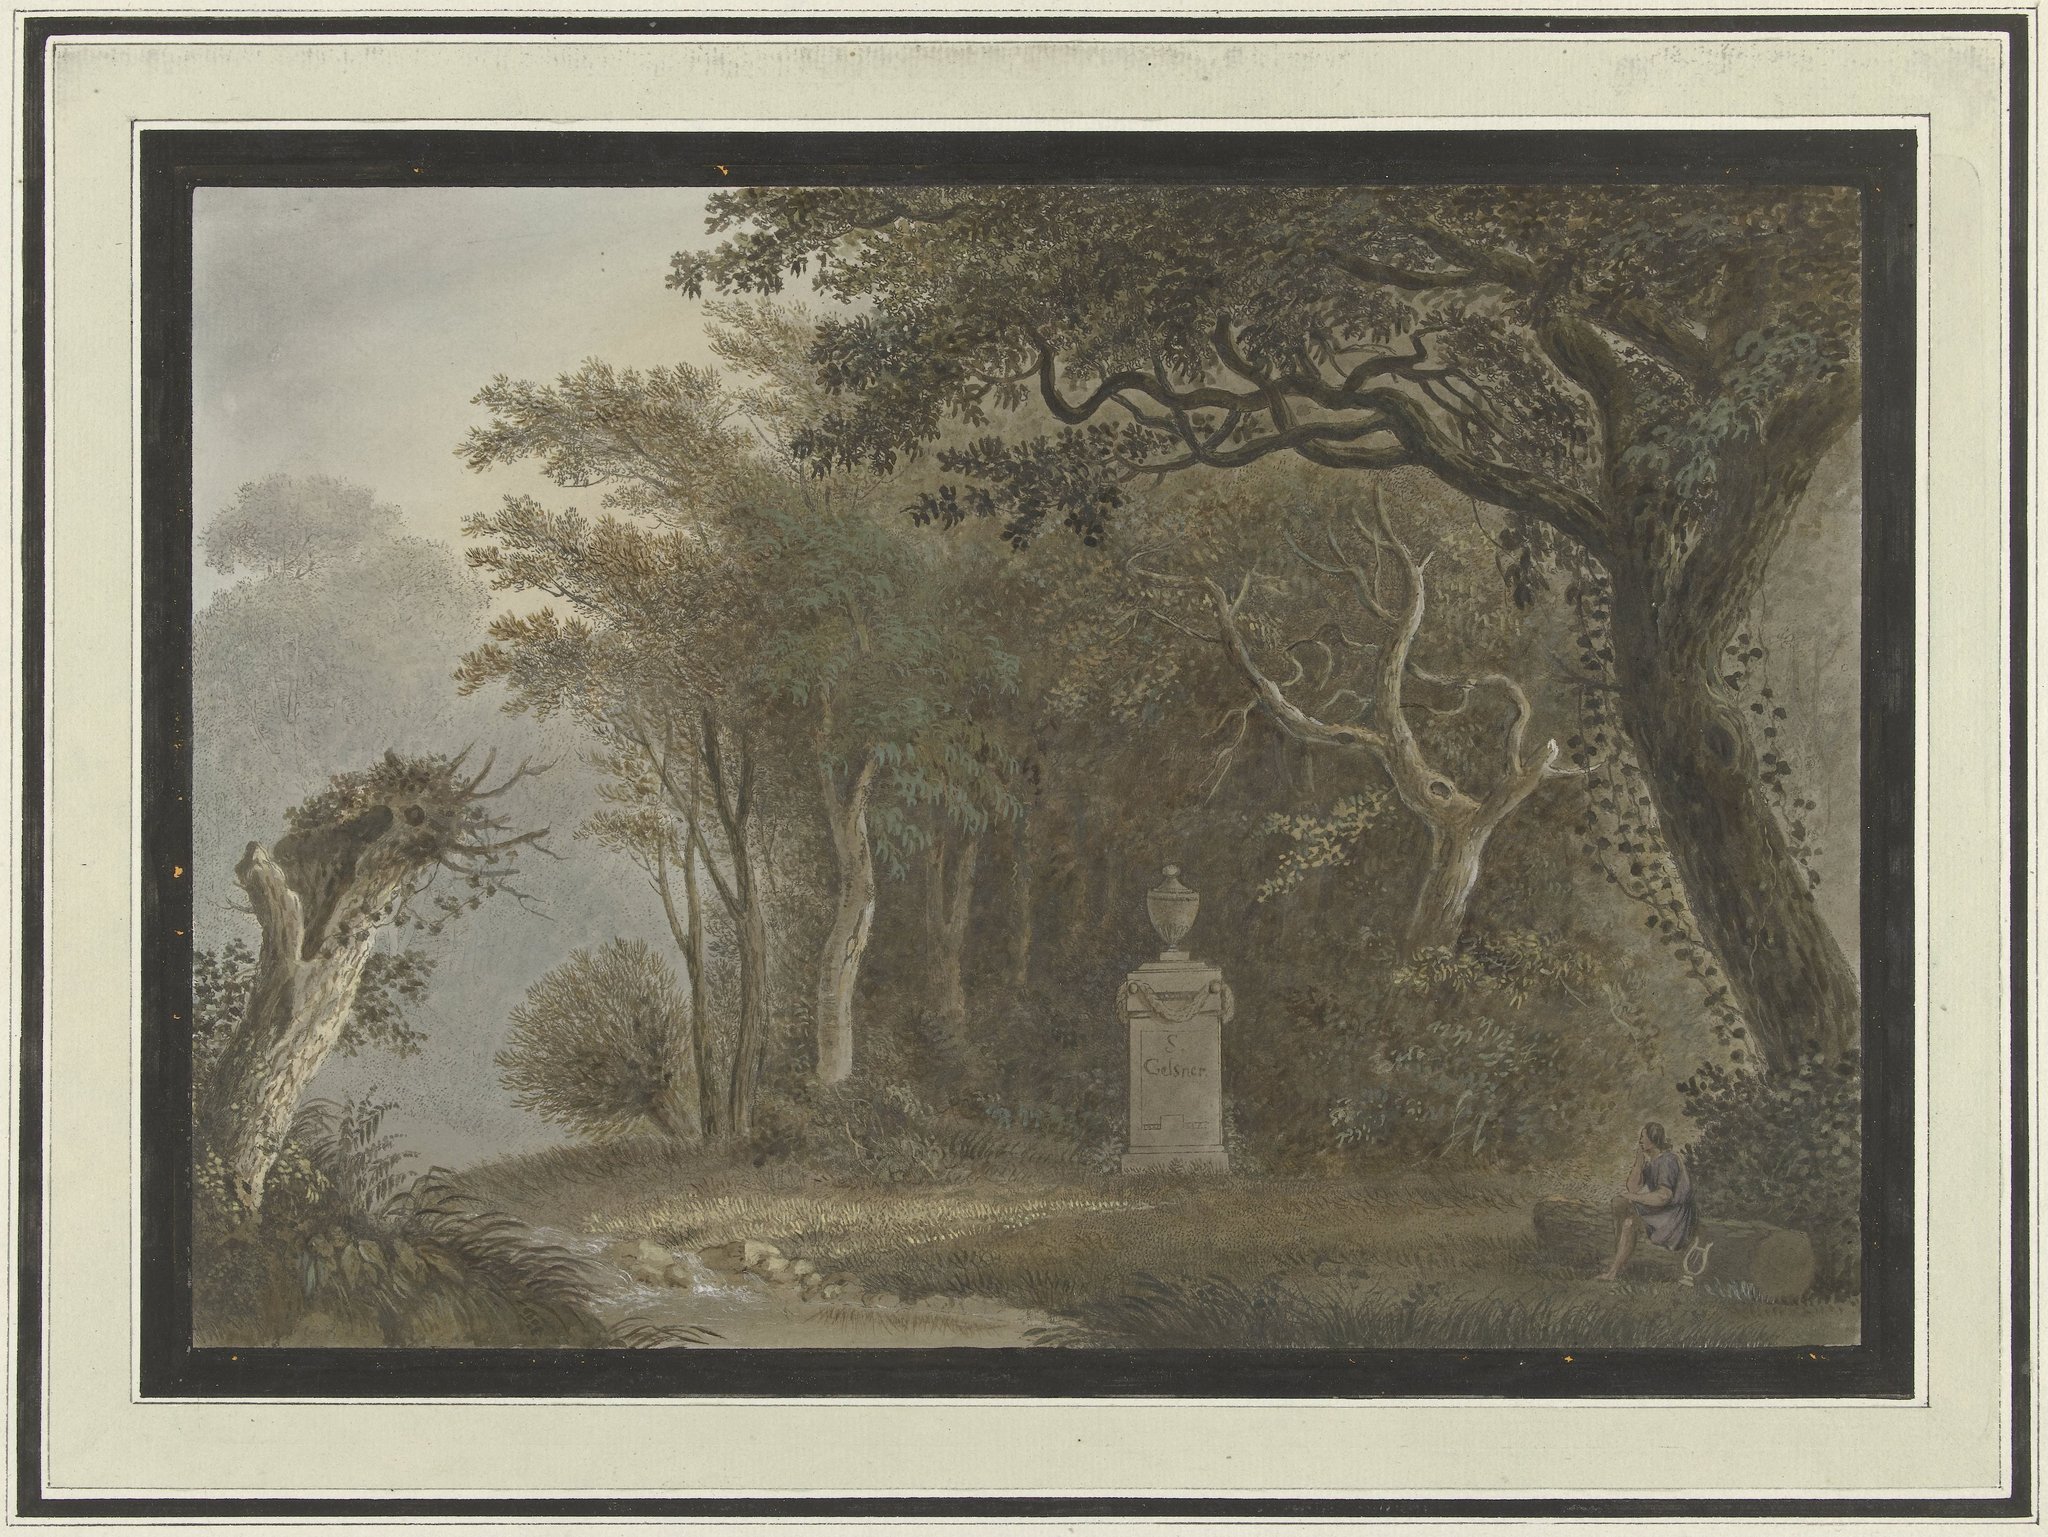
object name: watercolor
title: Boslandschap met monument voor Salomon Gessner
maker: Anonymous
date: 1740-1800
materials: paper, watercolor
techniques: brush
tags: painter, salomon gessner, historical persons, landscape with monument, forest, wood, grave-building, monumental tomb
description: Boslandschap met monument voor Salomon Gessner (1730-1788); rechts op de voorgrond een man met een lier.